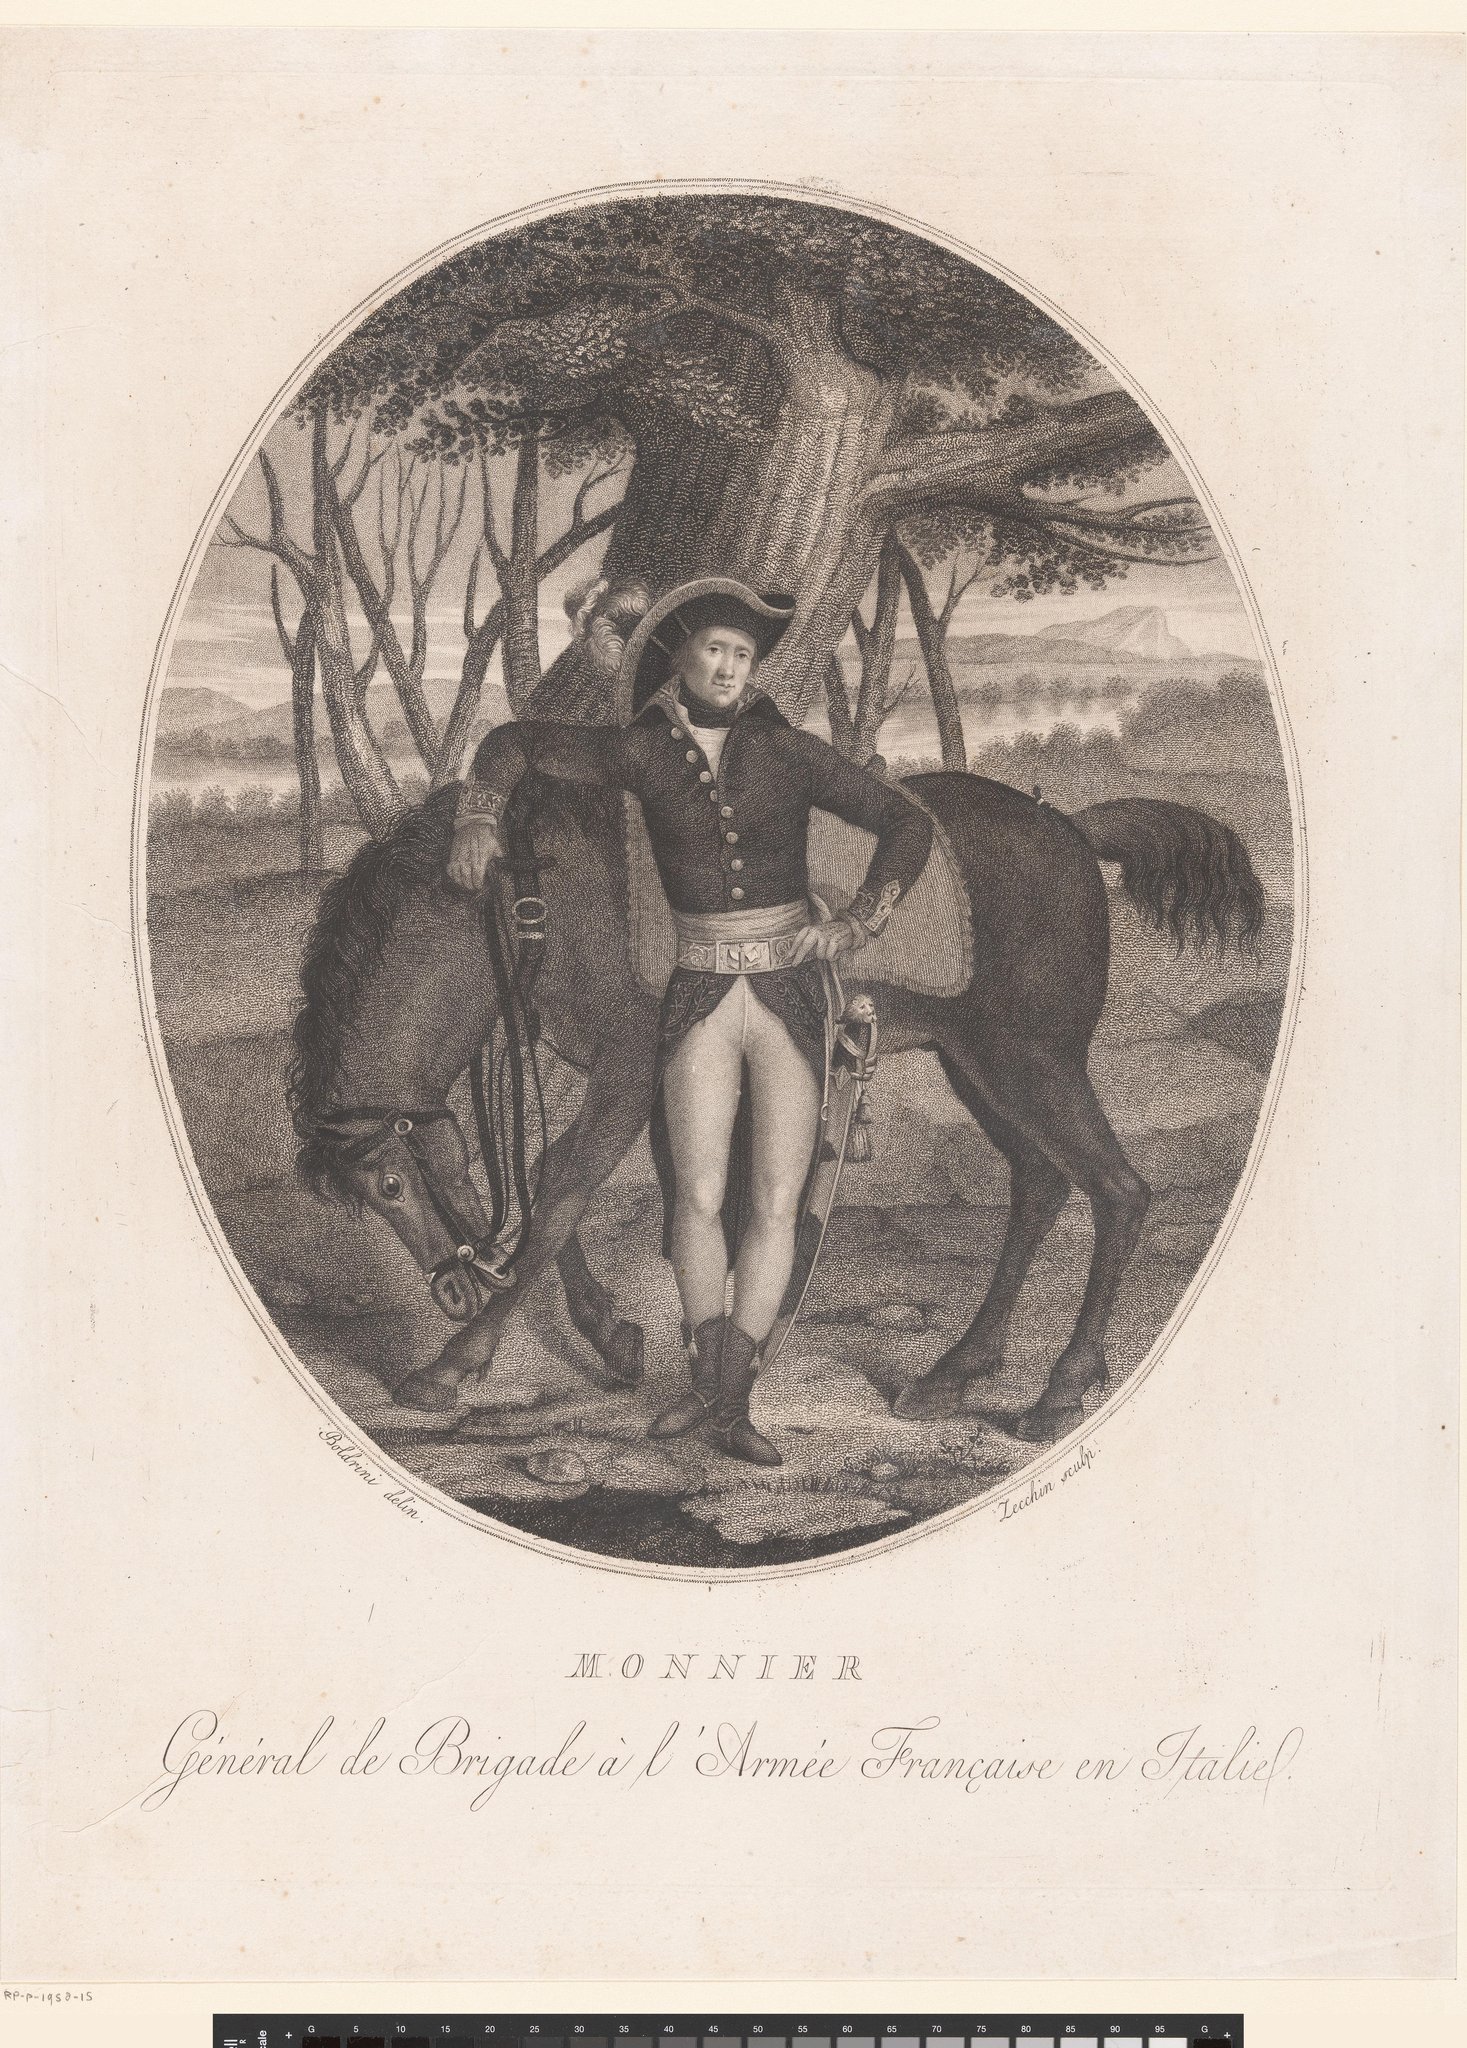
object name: print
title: Monnier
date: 1790-1880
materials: paper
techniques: engraving, etching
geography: italy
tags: historical persons, horse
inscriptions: collector's mark: Lugt 2228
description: Portret van een man te paard, volgens het onderschrift genaamd Monnier, brigade-generaal van het Franse leger in Italië.